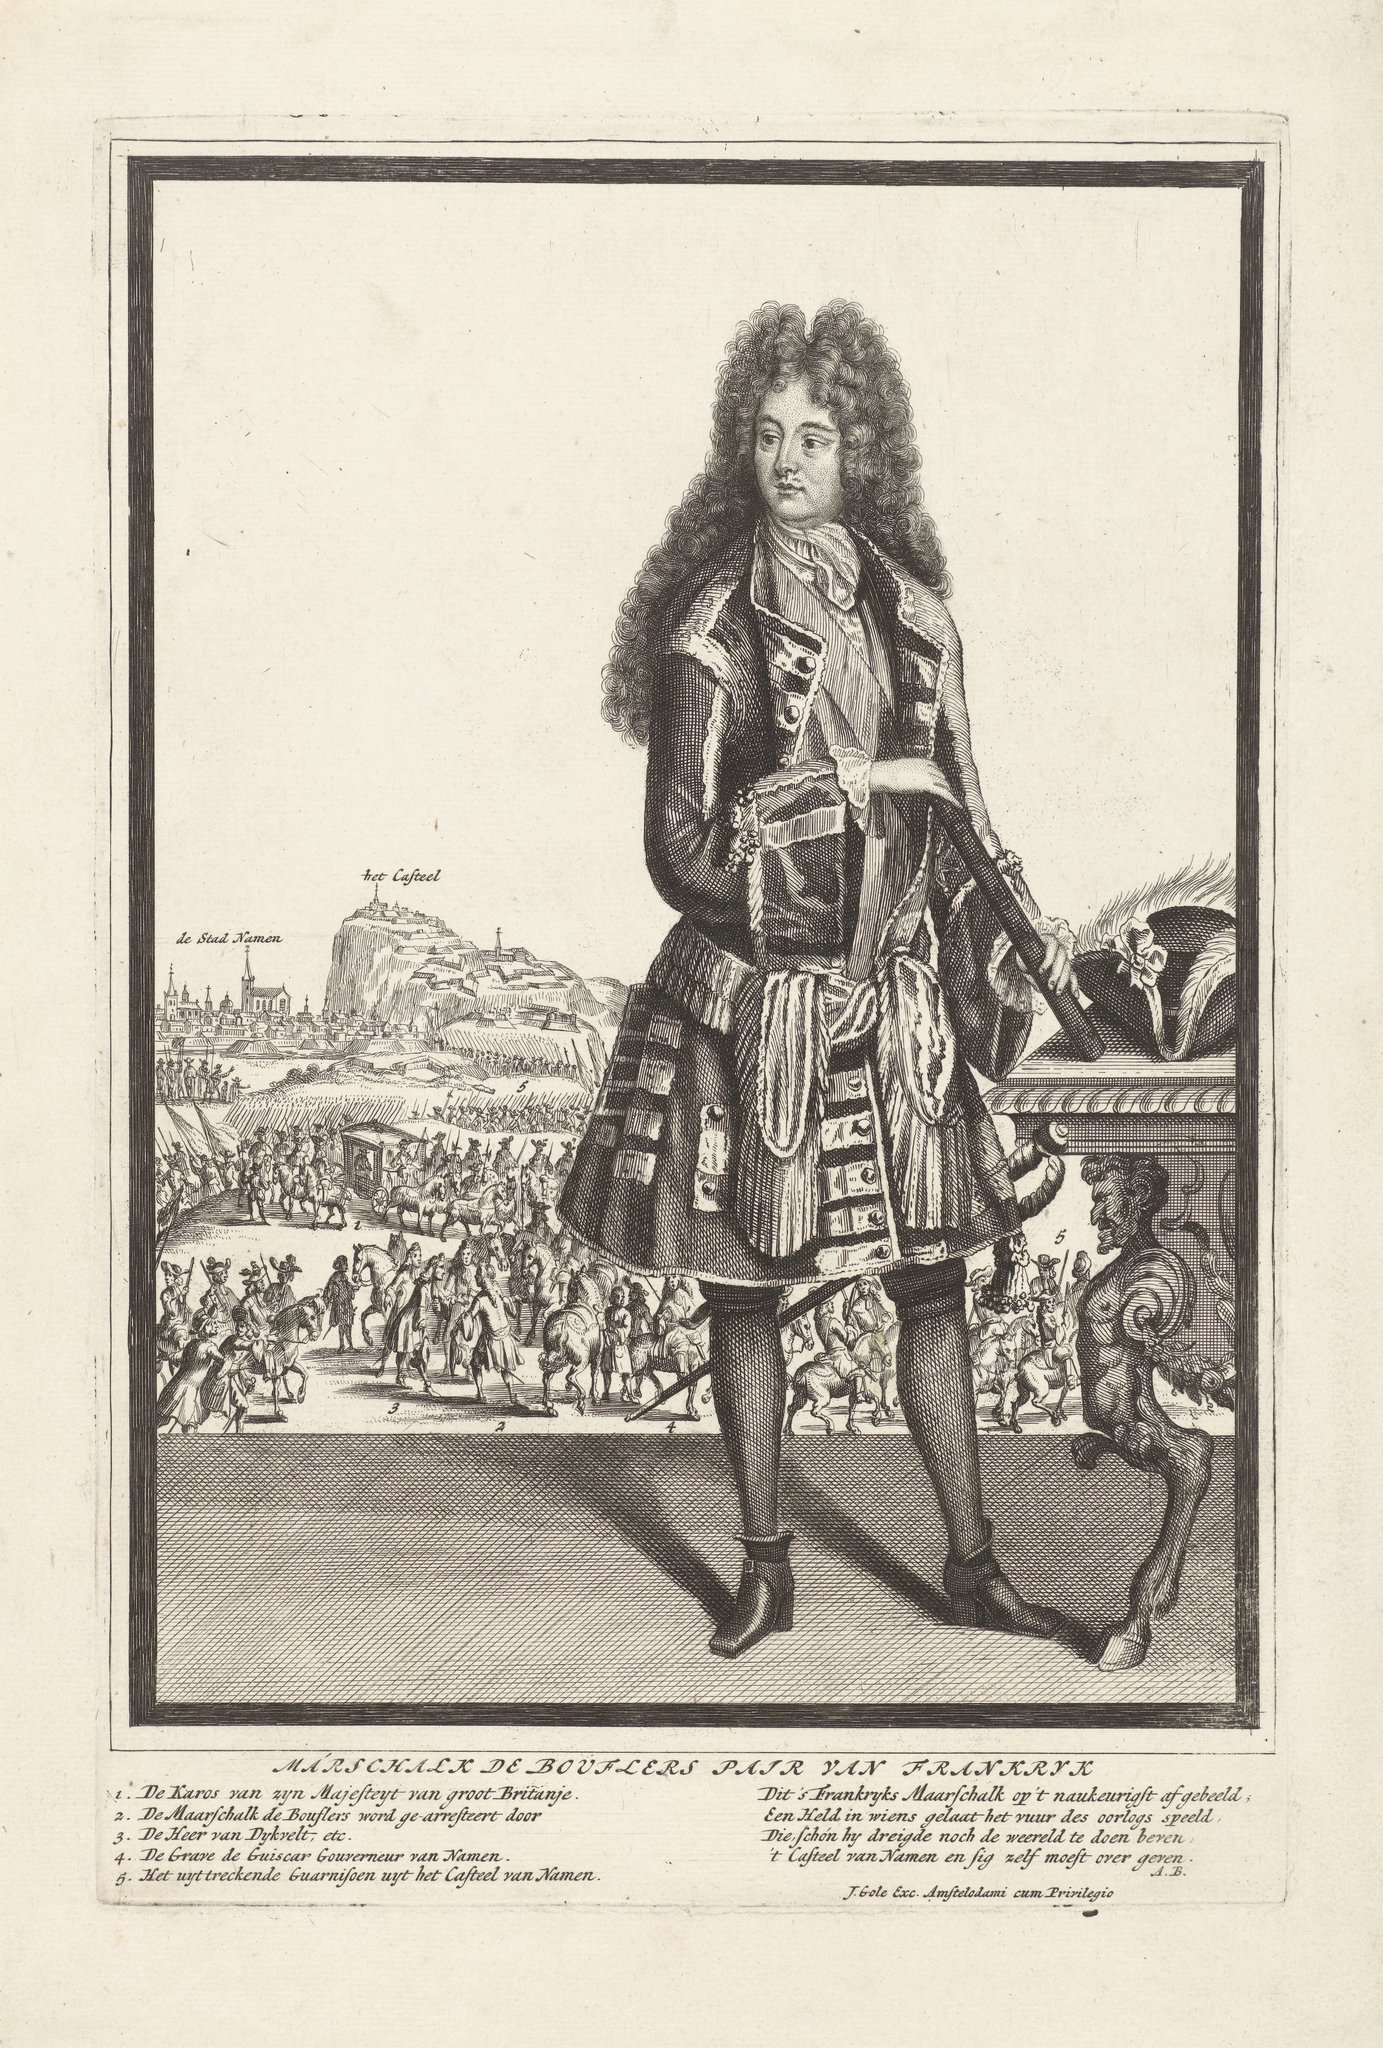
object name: print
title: Márschalk de Bouflers / Pair van Frankryk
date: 1695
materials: paper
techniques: etching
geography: amsterdam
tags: head-gear: tricorn (+ men's clothes), clothing for the upper part of the body (vest) (+ men's clothes), neck-gear ~ clothing (cravat) (+ men's clothes), styles of hairdress (allonge), coat (justaucorps) (+ men's clothes), shoes, sandals (+ men's clothes), clothes, costume (+ men's clothes)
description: Portret van maarschalk Louis François, hertog van Boufflers en bevelhebber van de Franse troepen gelegerd in Namen. De maarschalk staat bij een tafeltje, op de achtergrond het beleg van Namen. Onder het portret een korte verklaring van de cijfers in de voorstelling en een vierregelig vers gesigneerd A.B.